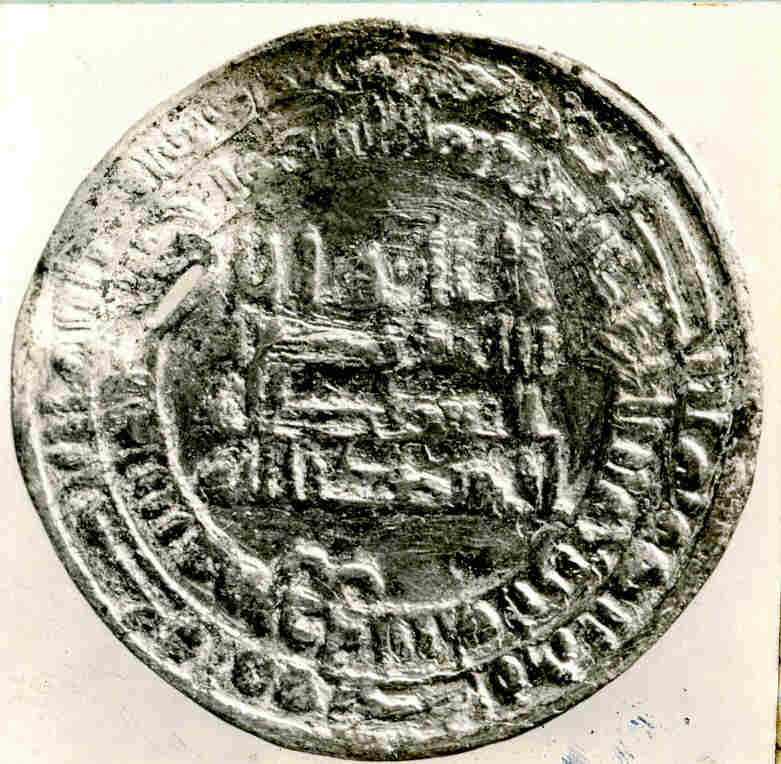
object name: coin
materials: silver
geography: qazween